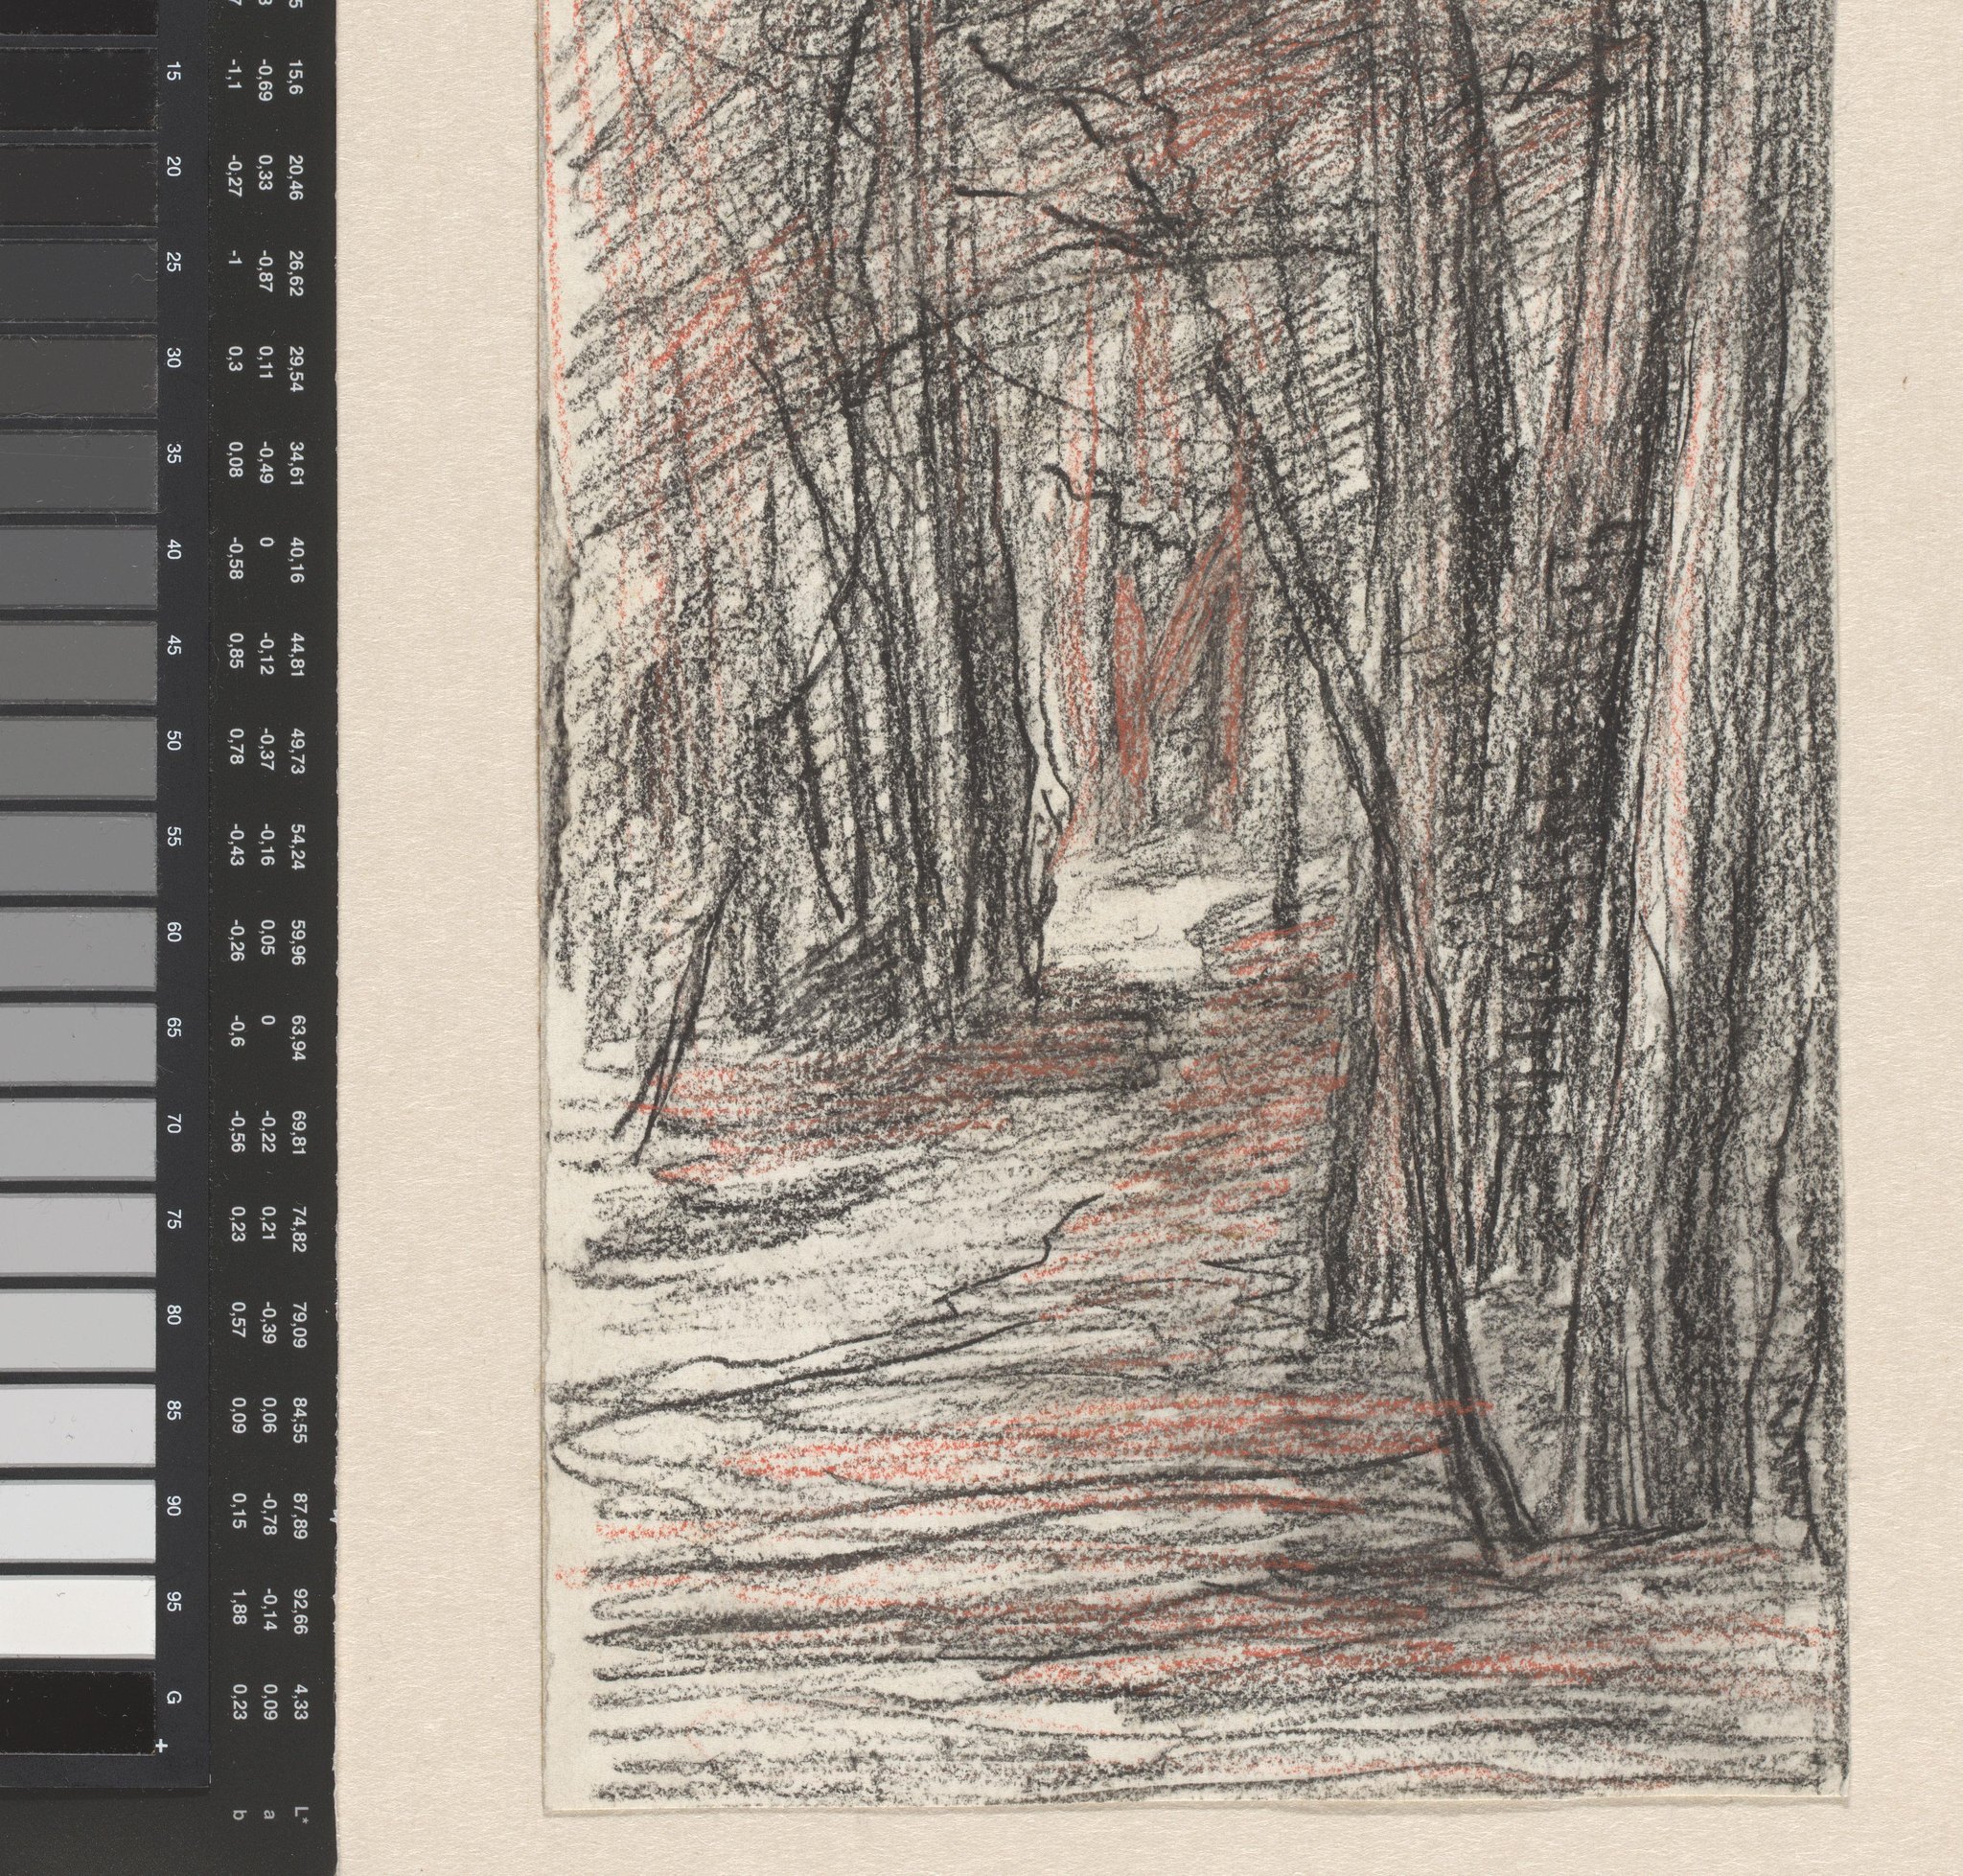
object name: drawing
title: Bomen langs een bospad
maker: sientje mesdag-van houten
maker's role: draughtsman, painter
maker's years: 1834-1909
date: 1880-1909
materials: chalk, paper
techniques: drawing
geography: netherlands